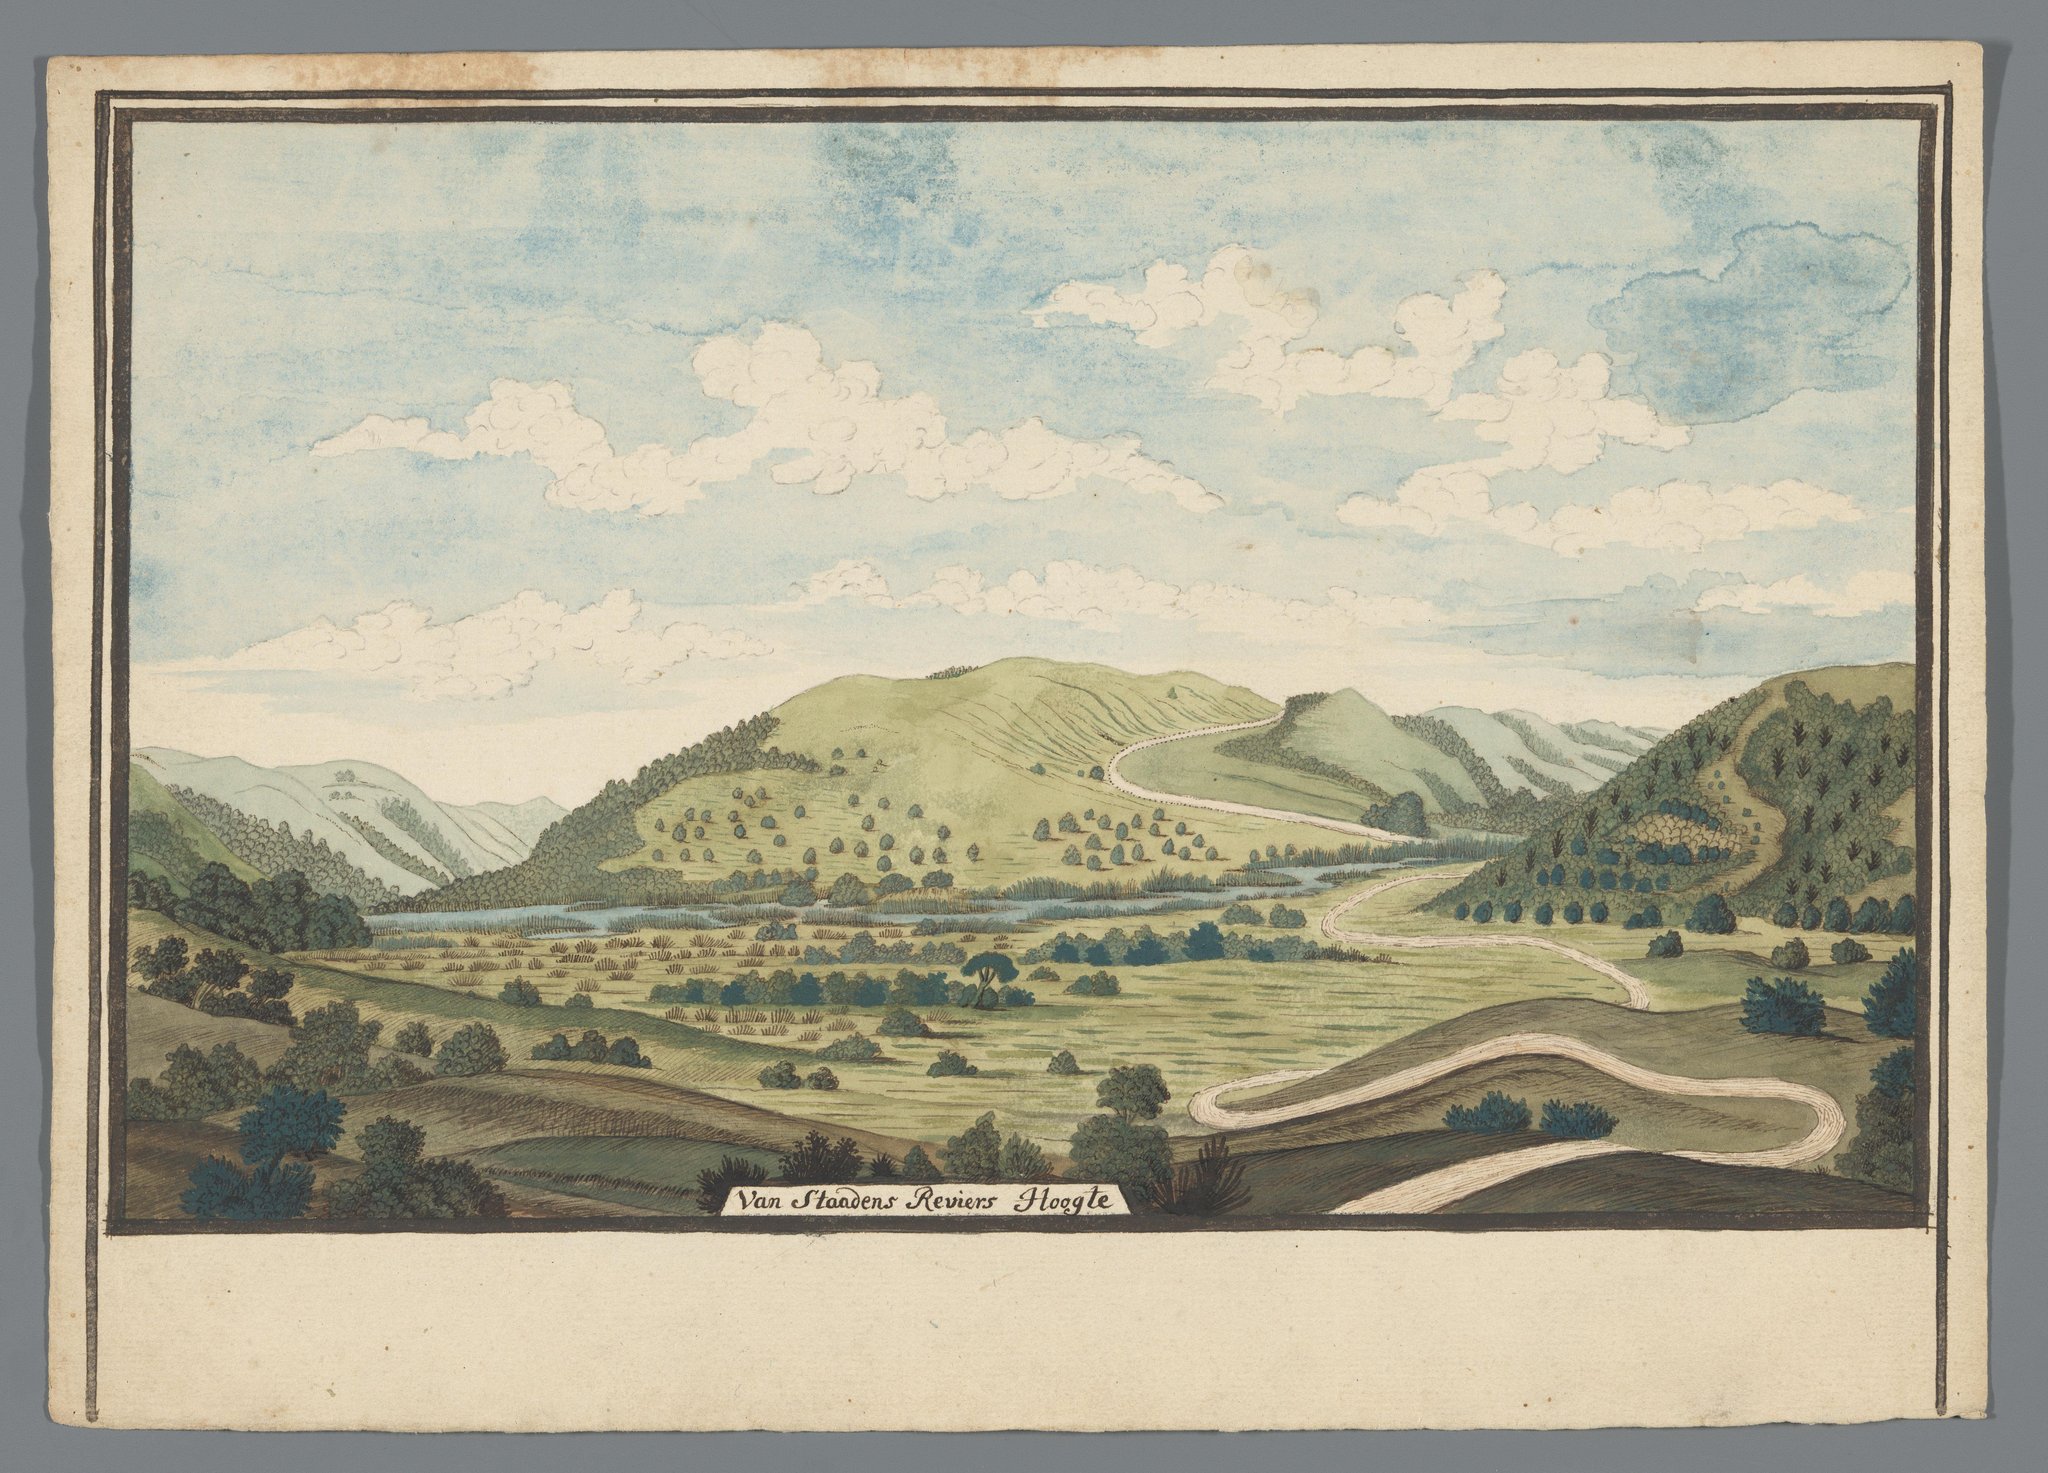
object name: drawing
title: De Van Stadensrivier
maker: johannes schumacher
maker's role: draughtsman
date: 1711-1776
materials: paper, watercolor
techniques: brush, pen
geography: south africa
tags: cape of good hope, river, mountains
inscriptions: label: ‘14’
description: De bovenloop van de Van Stadensrivier. Tekening gemaakt tijdens de tweede reis van Hendrik Swellengrebel, naar het noordoosten van de Kaapkolonie, 10 september - 26 december 1776. Volgens het reisjournaal bivakkeert het gezelschap op 18-19 november 1776 bij de rivier.